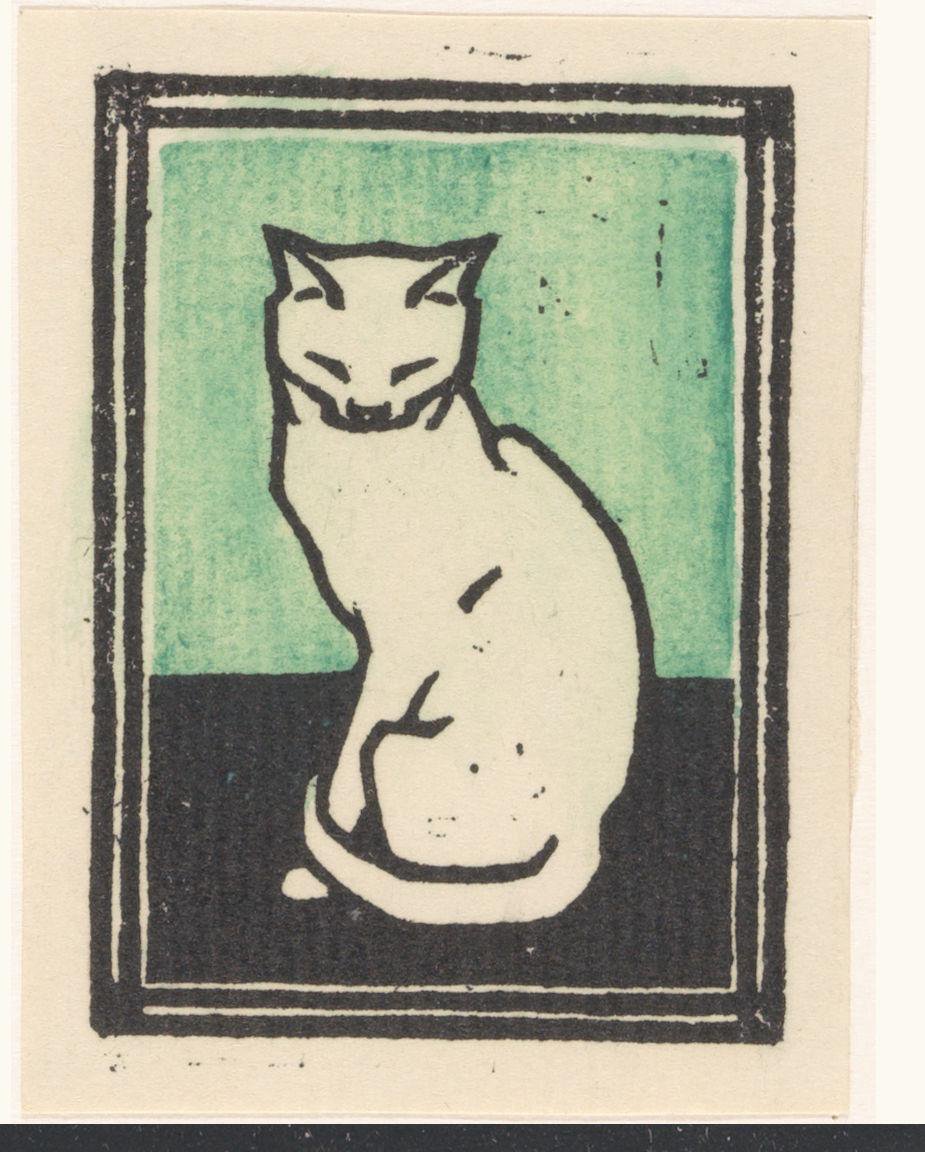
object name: print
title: Zittende kat met gesloten ogen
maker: julie de graag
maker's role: draughtsman, print maker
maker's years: 1877-1924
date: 1917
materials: paper, watercolor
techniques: hand coloring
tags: cat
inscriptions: collector's mark: Lugt 2228